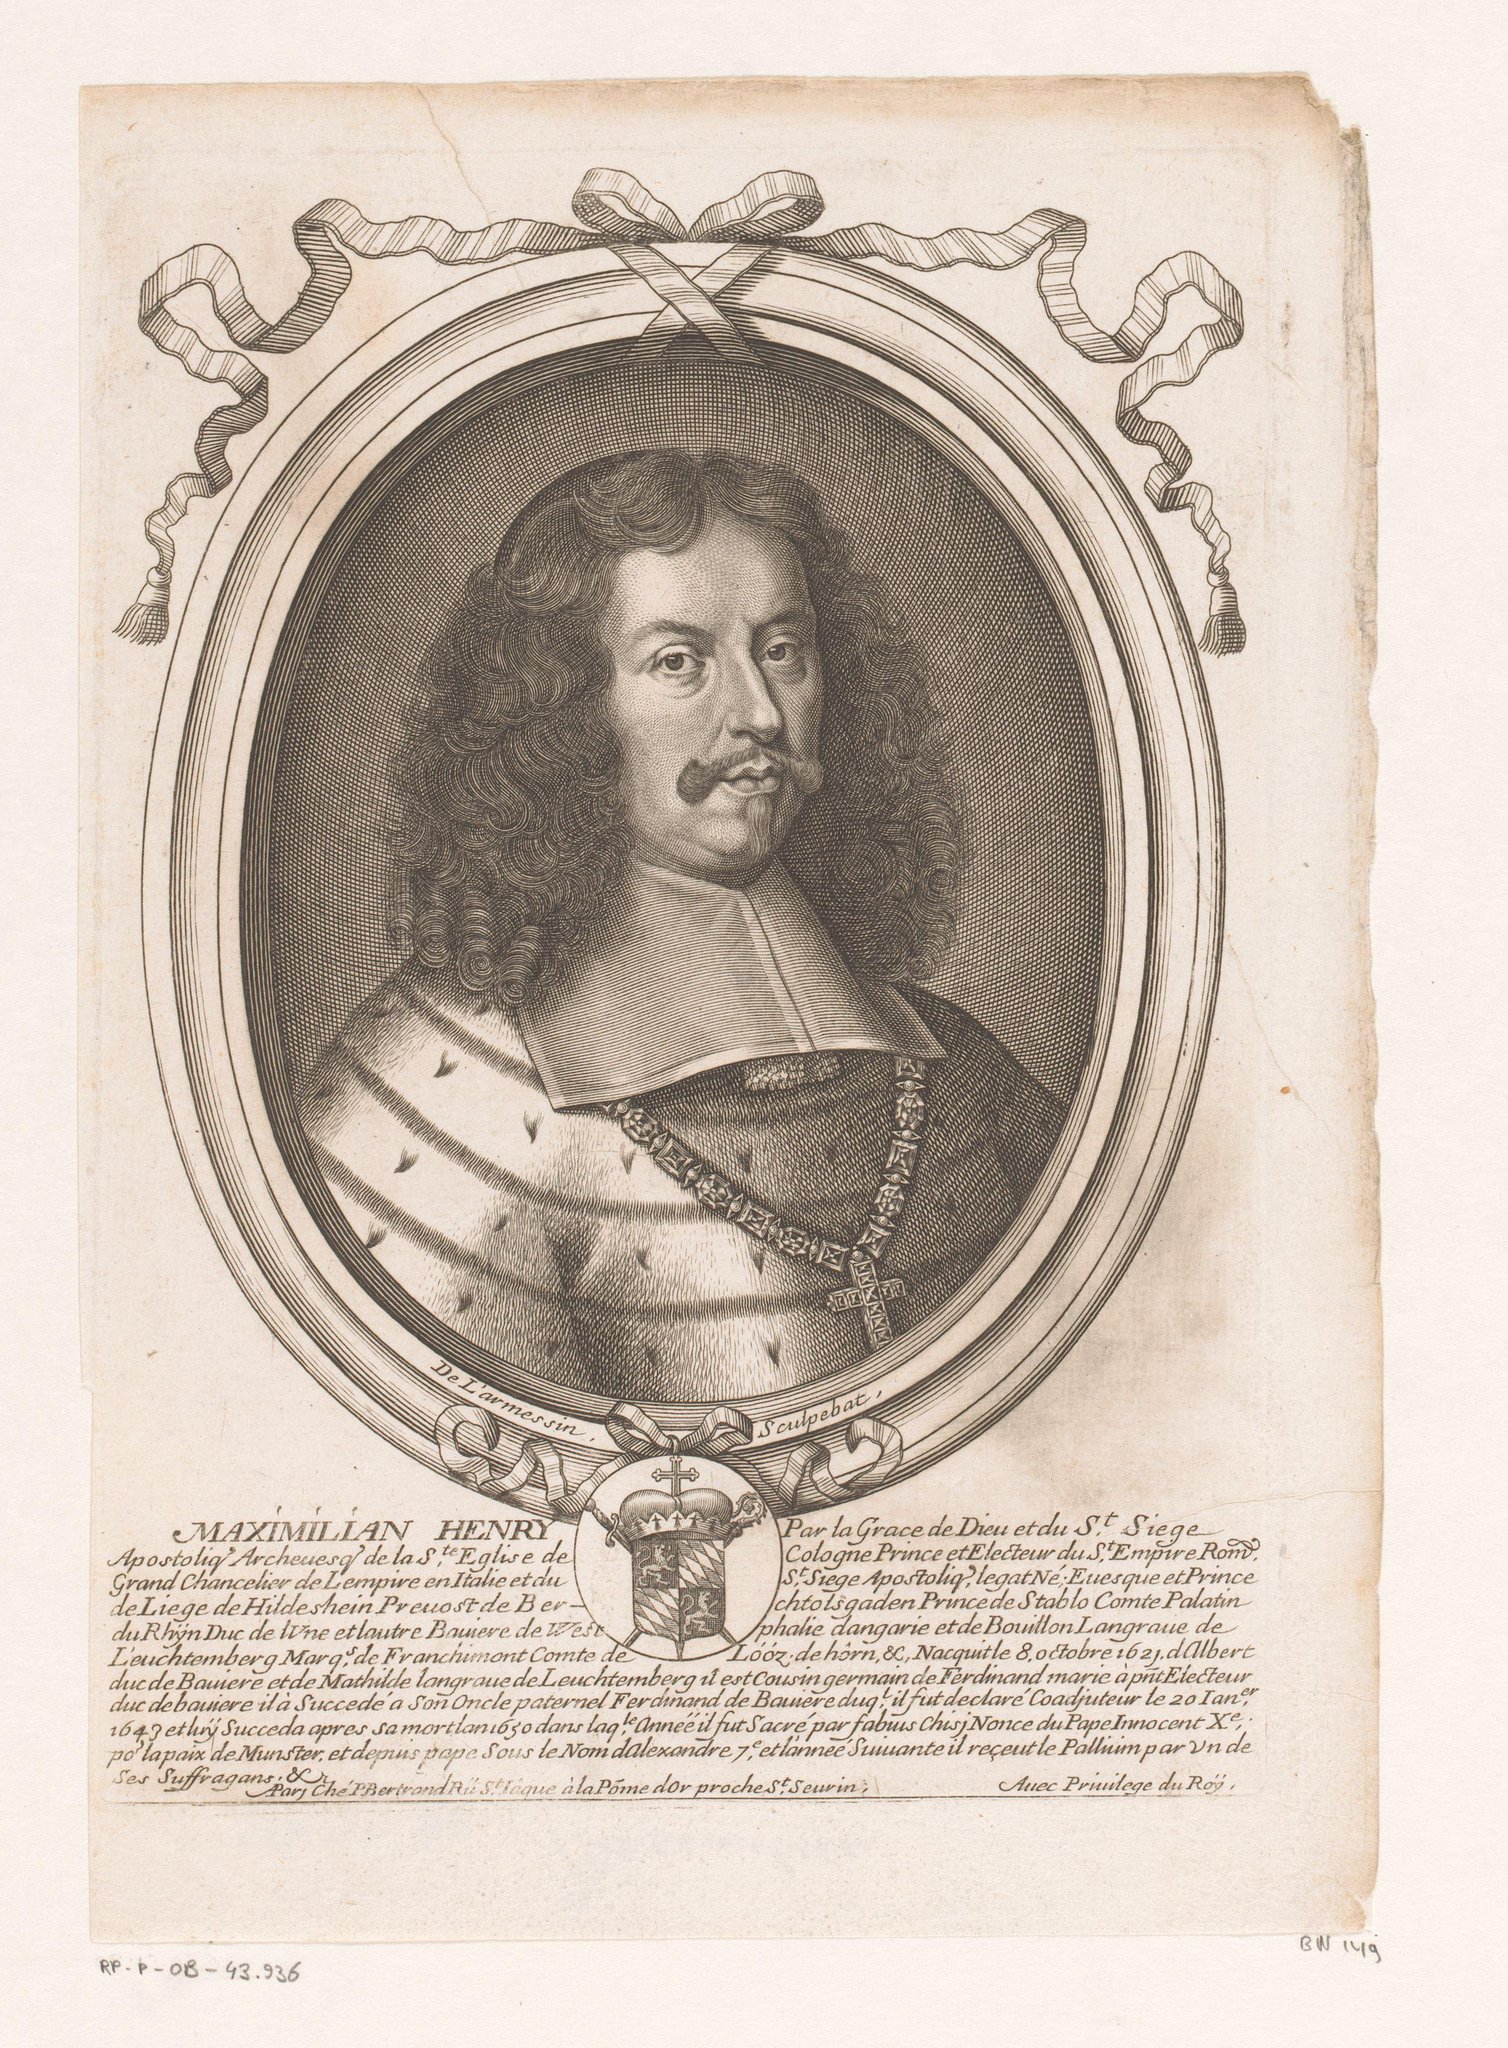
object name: print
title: Maximilian Henry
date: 1642-1678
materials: paper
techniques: engraving, etching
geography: france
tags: maximiliaan hendrik van beieren, historical persons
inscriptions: collector's mark: Lugt 2228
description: Maakt deel uit van een grootschalige serie met portretten van prominente figuren. Binnen de serie bevindt zich een sectie getiteld 'Les Augustes Représentations De tous les Roys De France depuis Pharamond Iusqu'à Louys XIIII'. De serie werd respectievelijk uitgegeven door Pierre Bertrand, door zijn weduwe en door De Larmessin zelf.